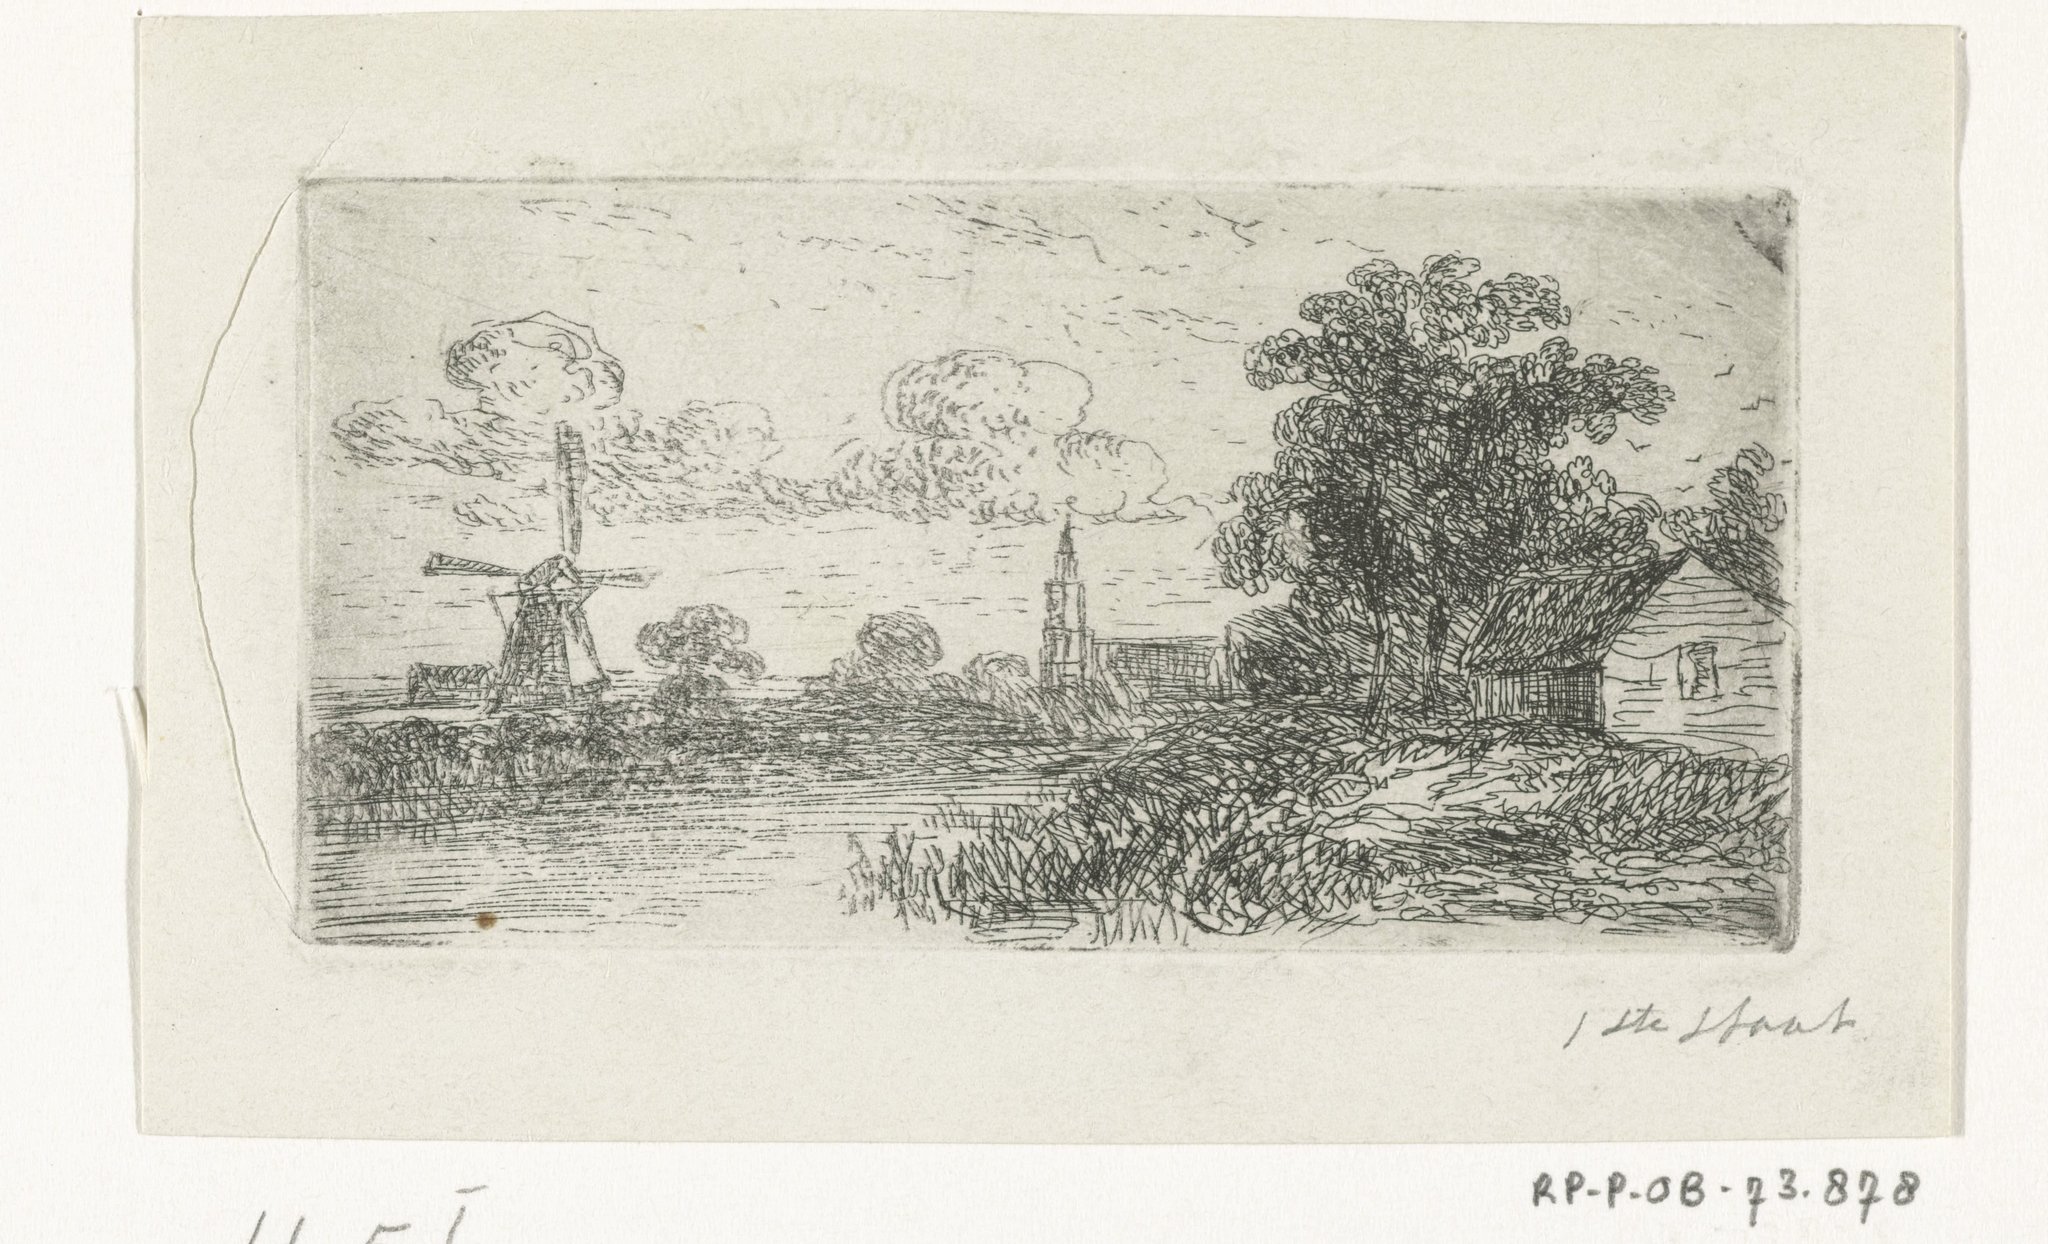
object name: print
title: Landschap met molen en kerk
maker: hermanus jan hendrik van rijkelijkhuysen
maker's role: painter, print maker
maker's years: 1813-1883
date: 1823-1883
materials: paper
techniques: etching, intaglio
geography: utrecht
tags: river, church (exterior), windmill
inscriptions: collector's mark: Lugt 2228